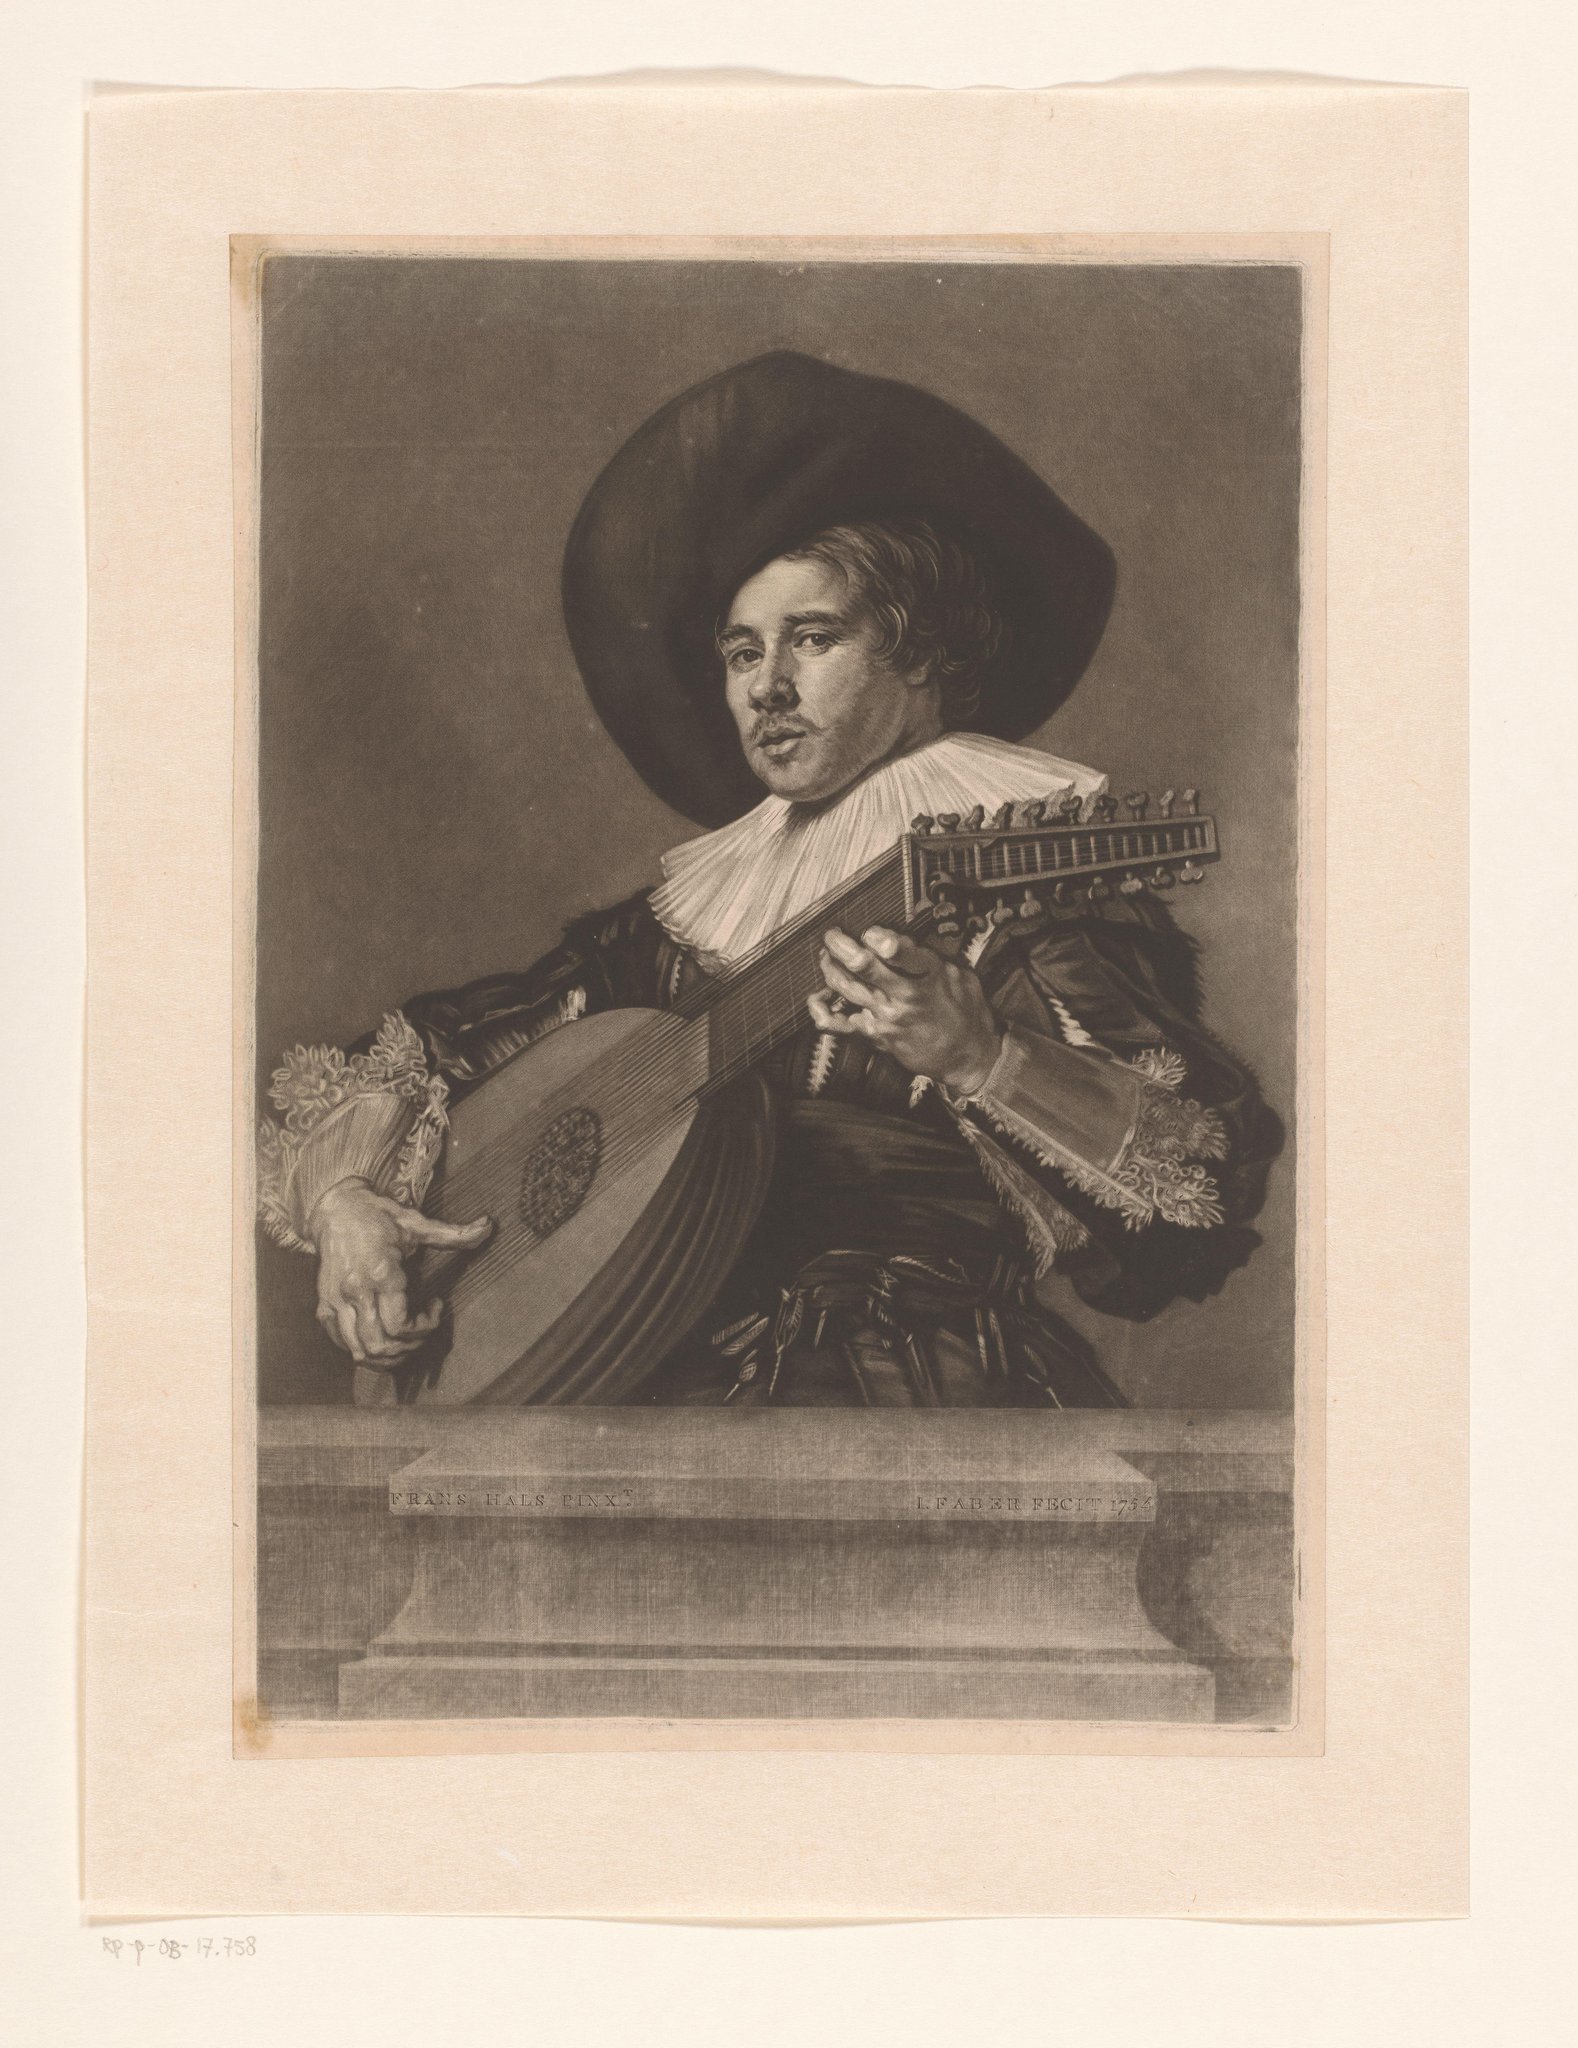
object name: print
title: Man met een luit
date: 1754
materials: paper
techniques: etching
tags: musician, adult man, lute, and special forms of lute, e.g.: theorbo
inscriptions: collector's mark: Lugt 240